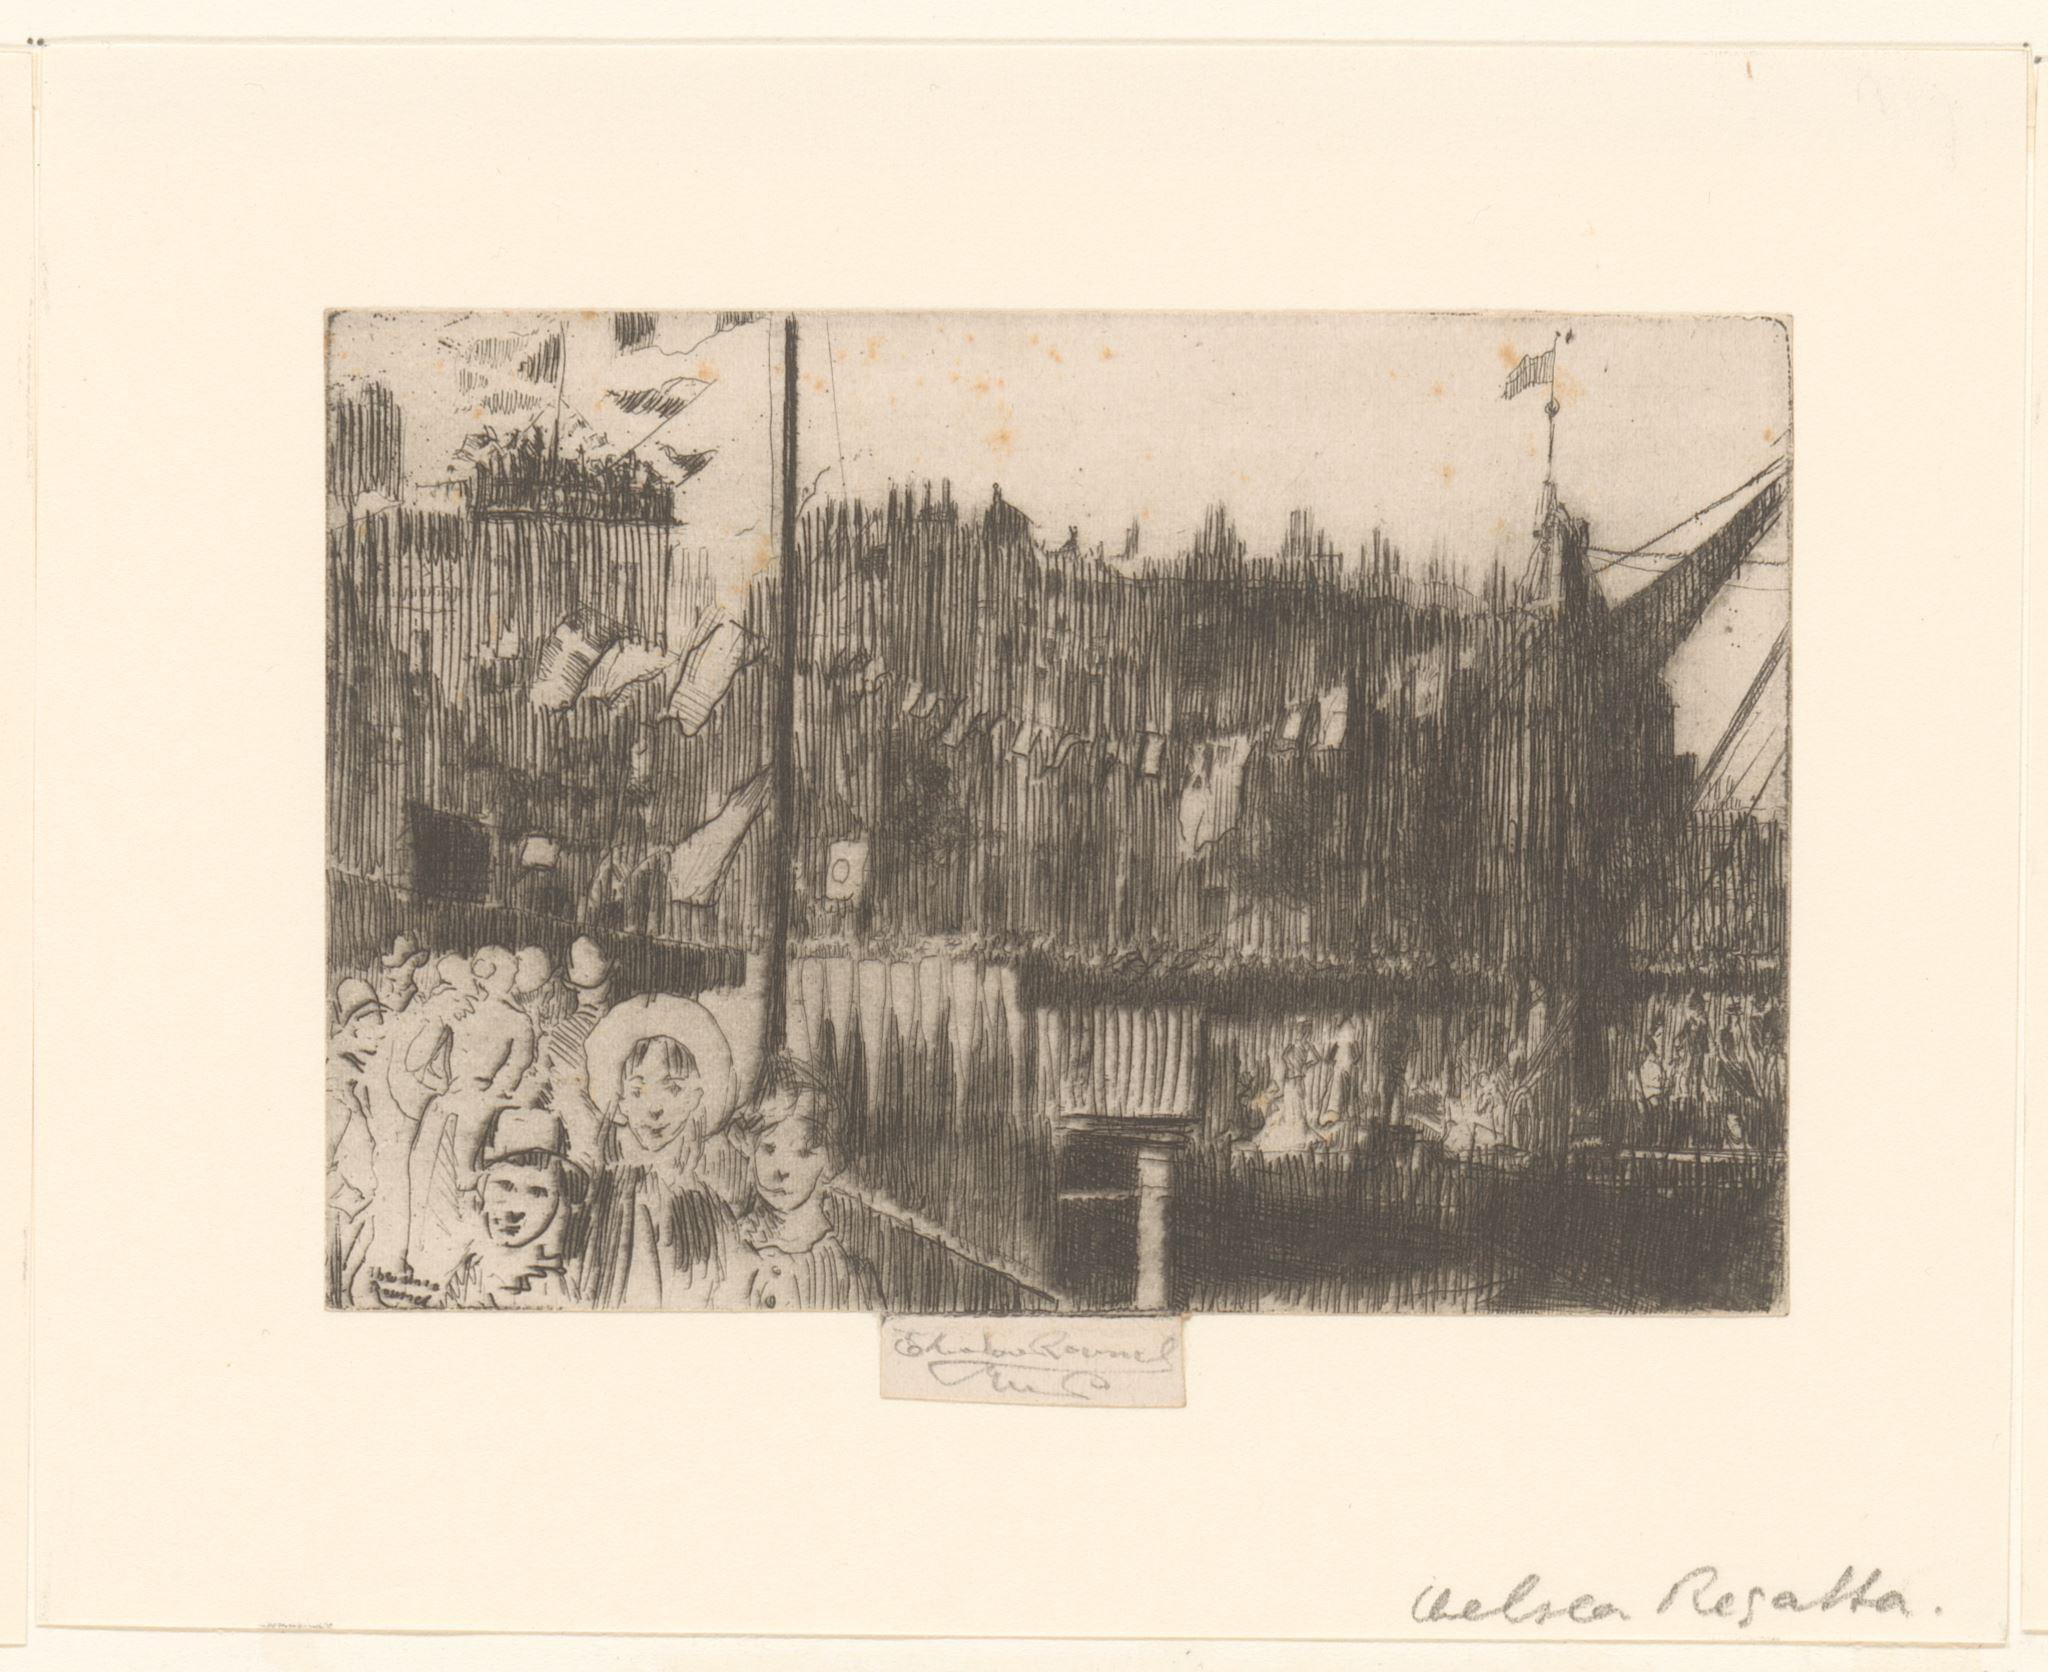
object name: print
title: Stadsgezicht met figuren op met vlaggen versierde kade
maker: théodore roussel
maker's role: print maker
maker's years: 1847-1926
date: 1888-1889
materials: paper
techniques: etching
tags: canals, waters (in city), london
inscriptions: collector's mark: Lugt 2228, dedication: ‘To Hetty / Th R’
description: De drie kinderen links op de voorgrond zijn wellicht die van de kunstenaar: Raphael, Jeanne en Paul Roussel. Bron: Hausberg.